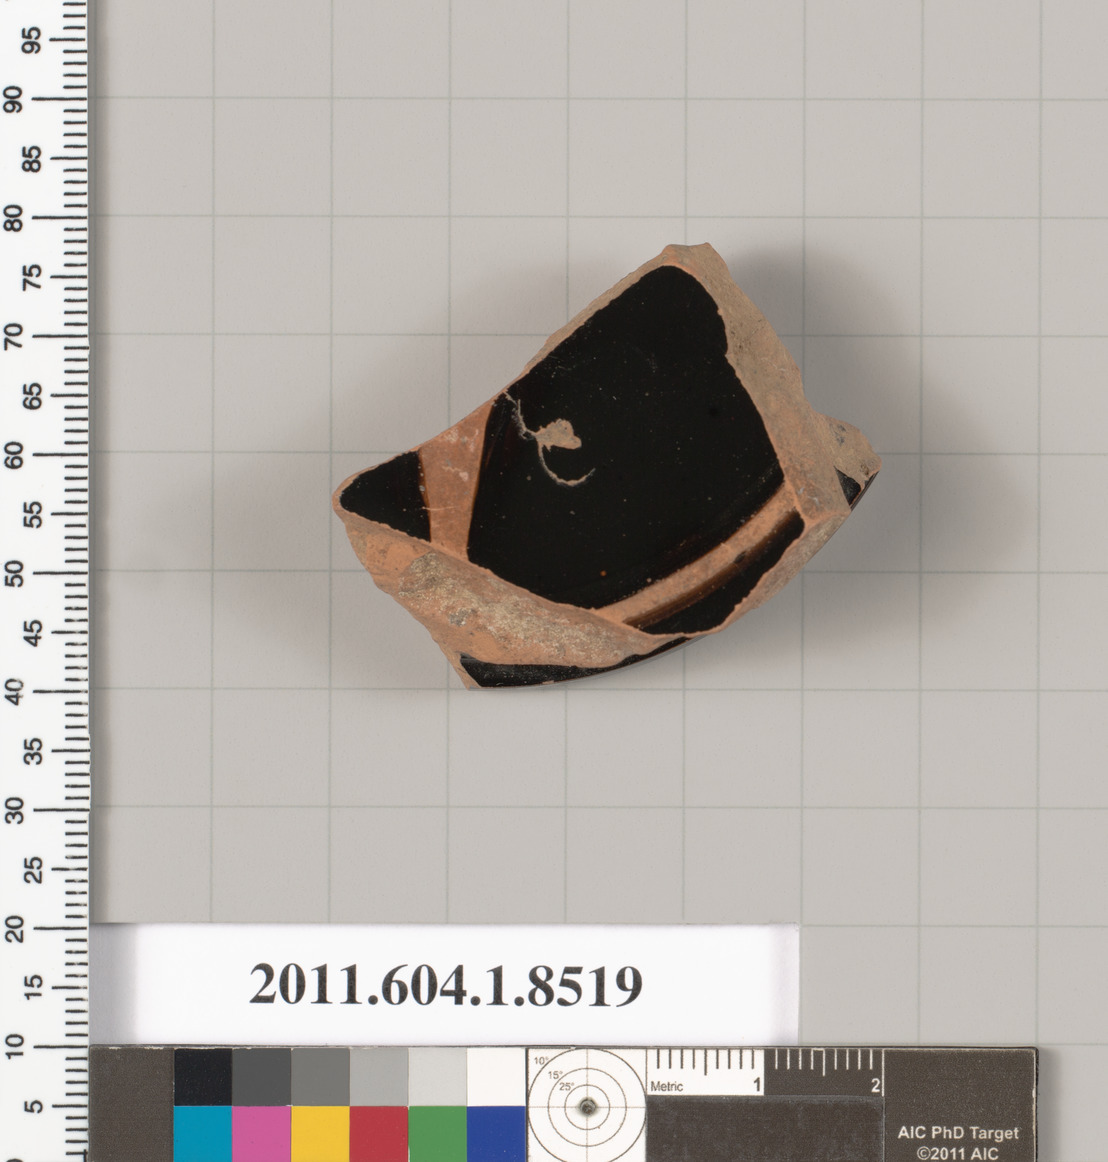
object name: kylix fragment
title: Terracotta fragment of a stemless kylix (drinking cup)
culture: greek, attic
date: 475-451 BCE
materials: terracotta